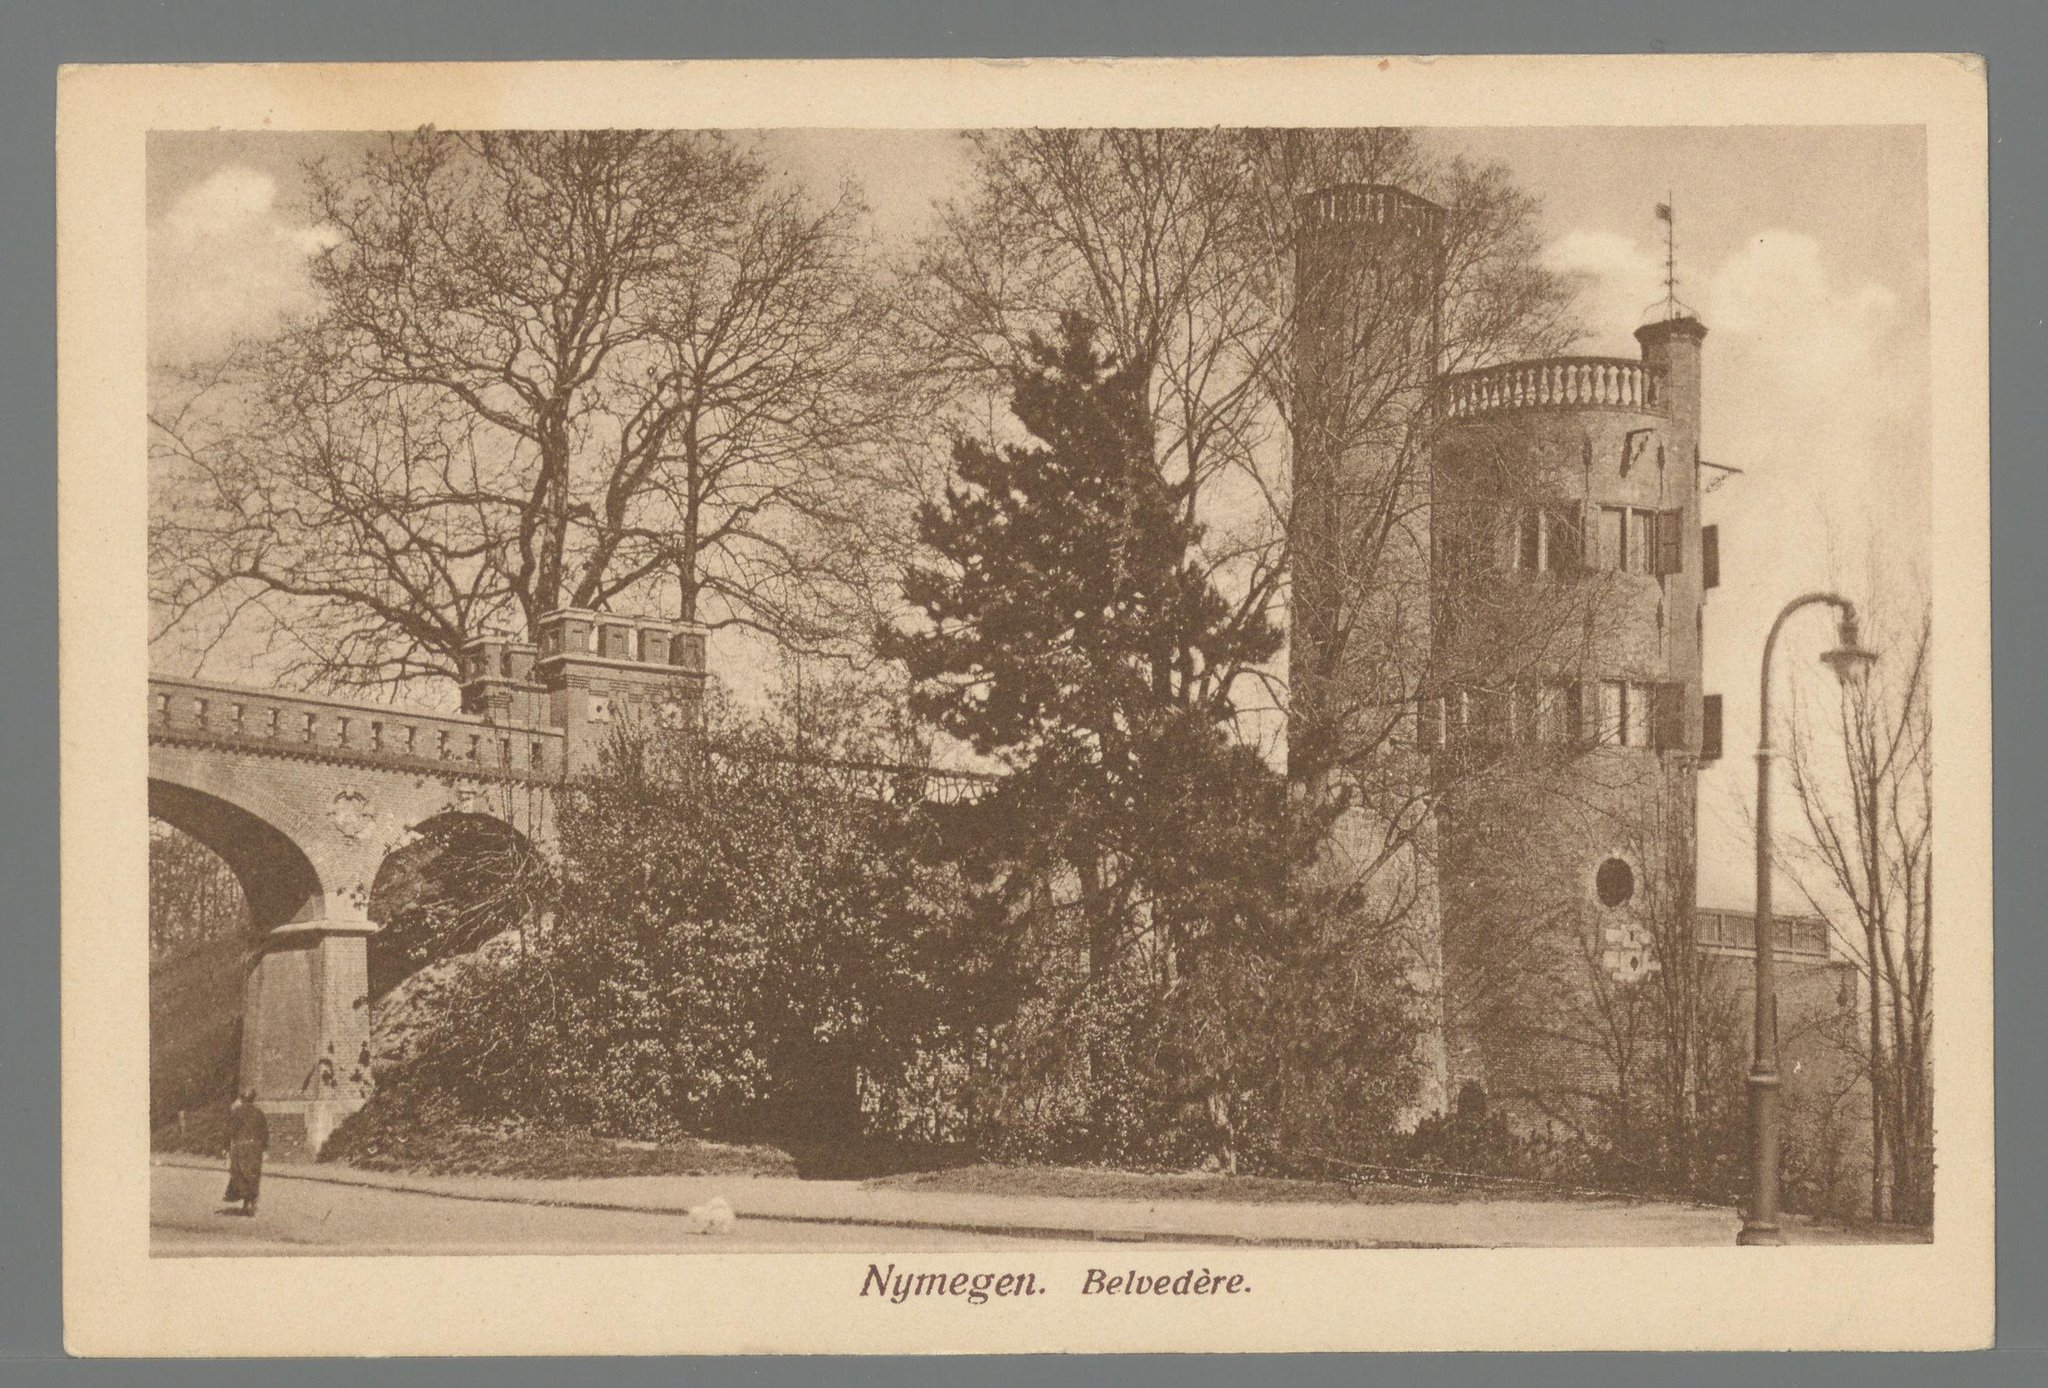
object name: ansichtkaart, prentbriefkaart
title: Nymegen. Belvedère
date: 1913-1950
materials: cardboard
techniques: photograph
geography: nijmegen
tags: belvedere